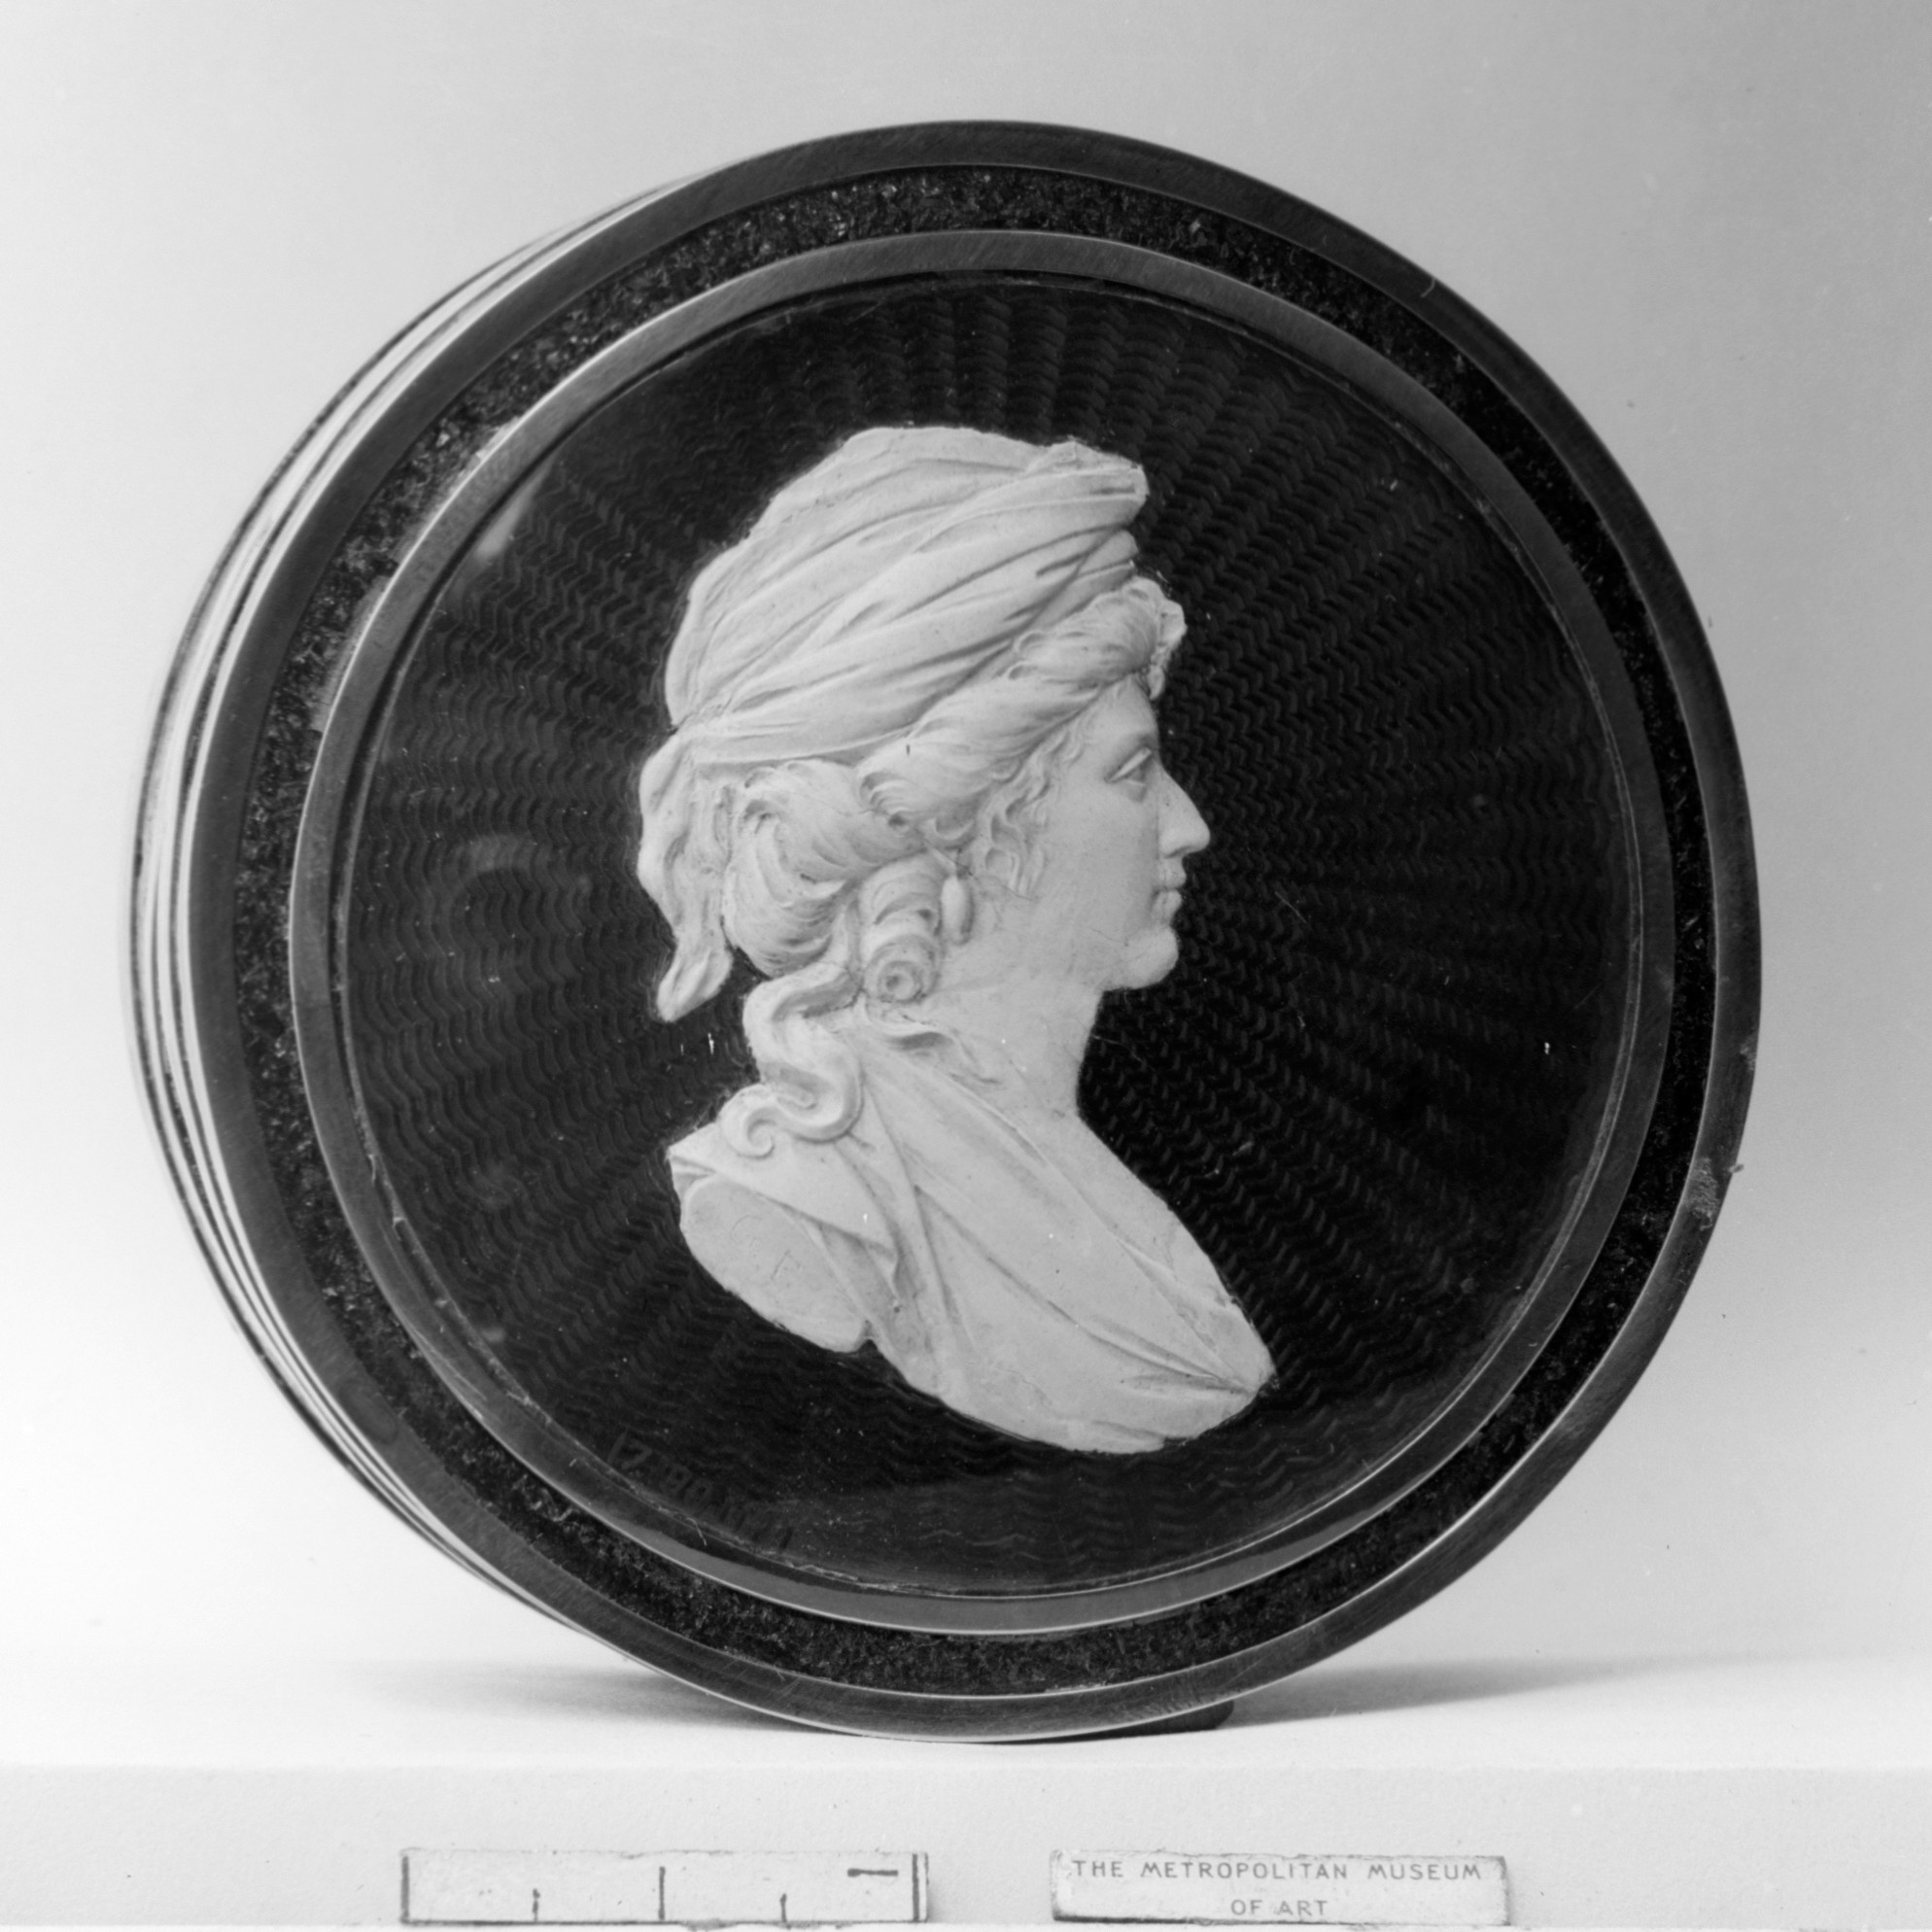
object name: box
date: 1767-1800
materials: gold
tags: profiles,women